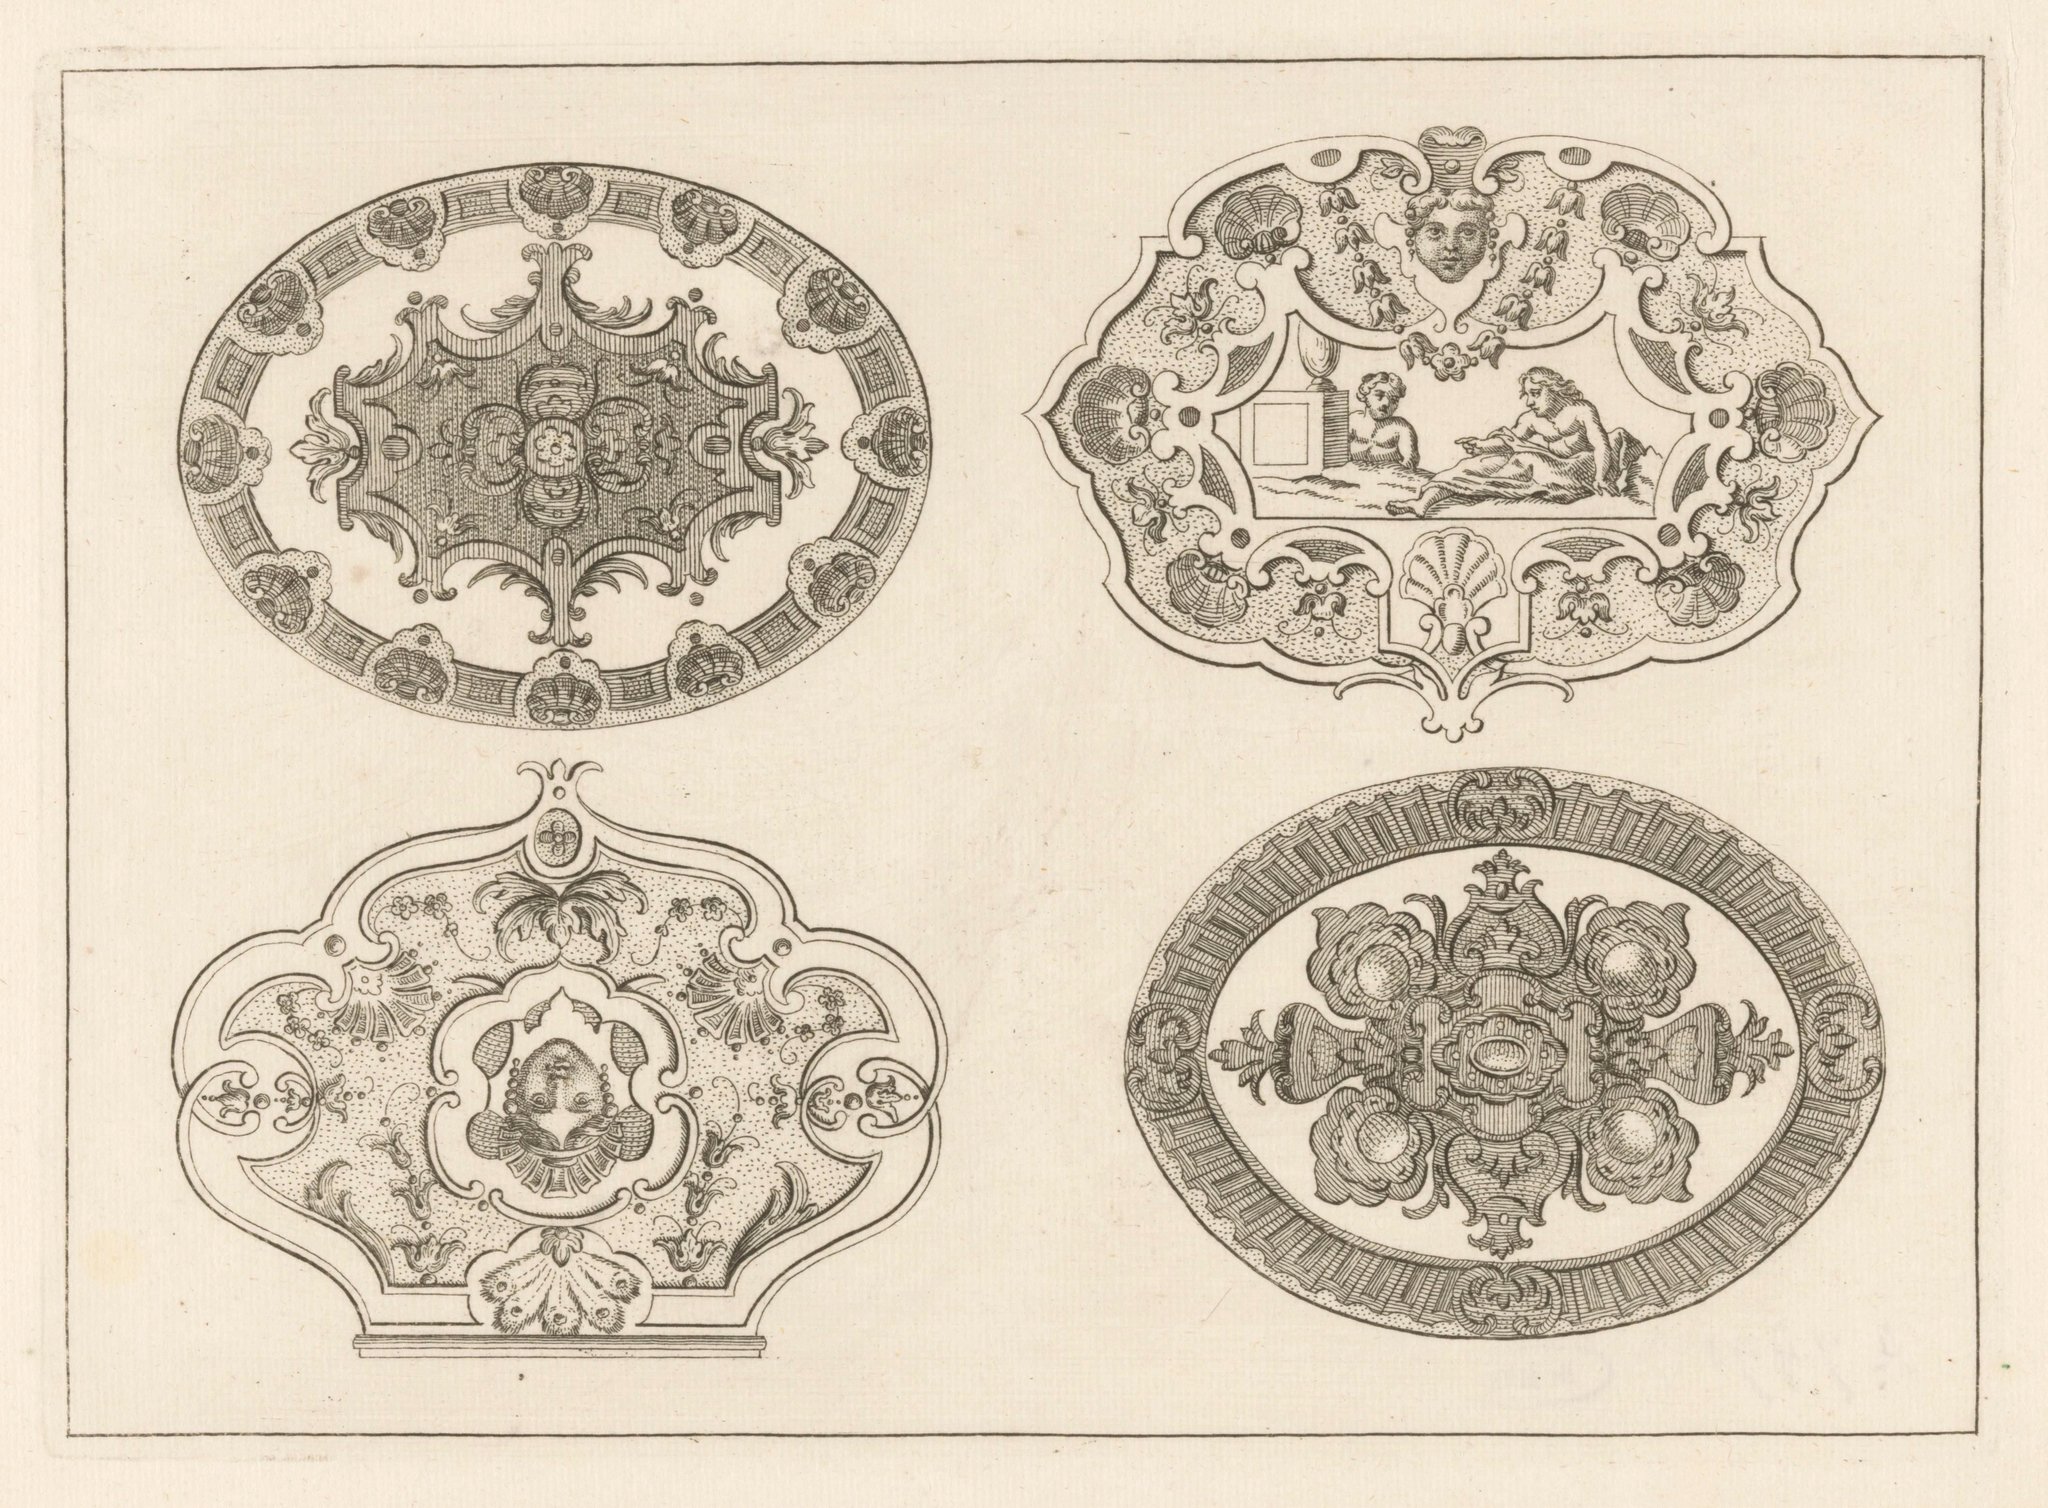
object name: ornament print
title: Neue invention oder entwurff von Schnupftoback Dosen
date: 1670-1725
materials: paper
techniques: etching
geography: germany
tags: ornaments ~ art, snuff-box, the (nude) human figure; 'corpo humano' (ripa)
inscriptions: collector's mark: Lugt 2228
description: Vier deksels van snuifdozen. Links boven en rechts onder met ornamenten en schelpmotieven. Rechts boven met schelpmotieven en twee figuren in een landschap. Links onder met schelp- en bladmotieven en een masker.